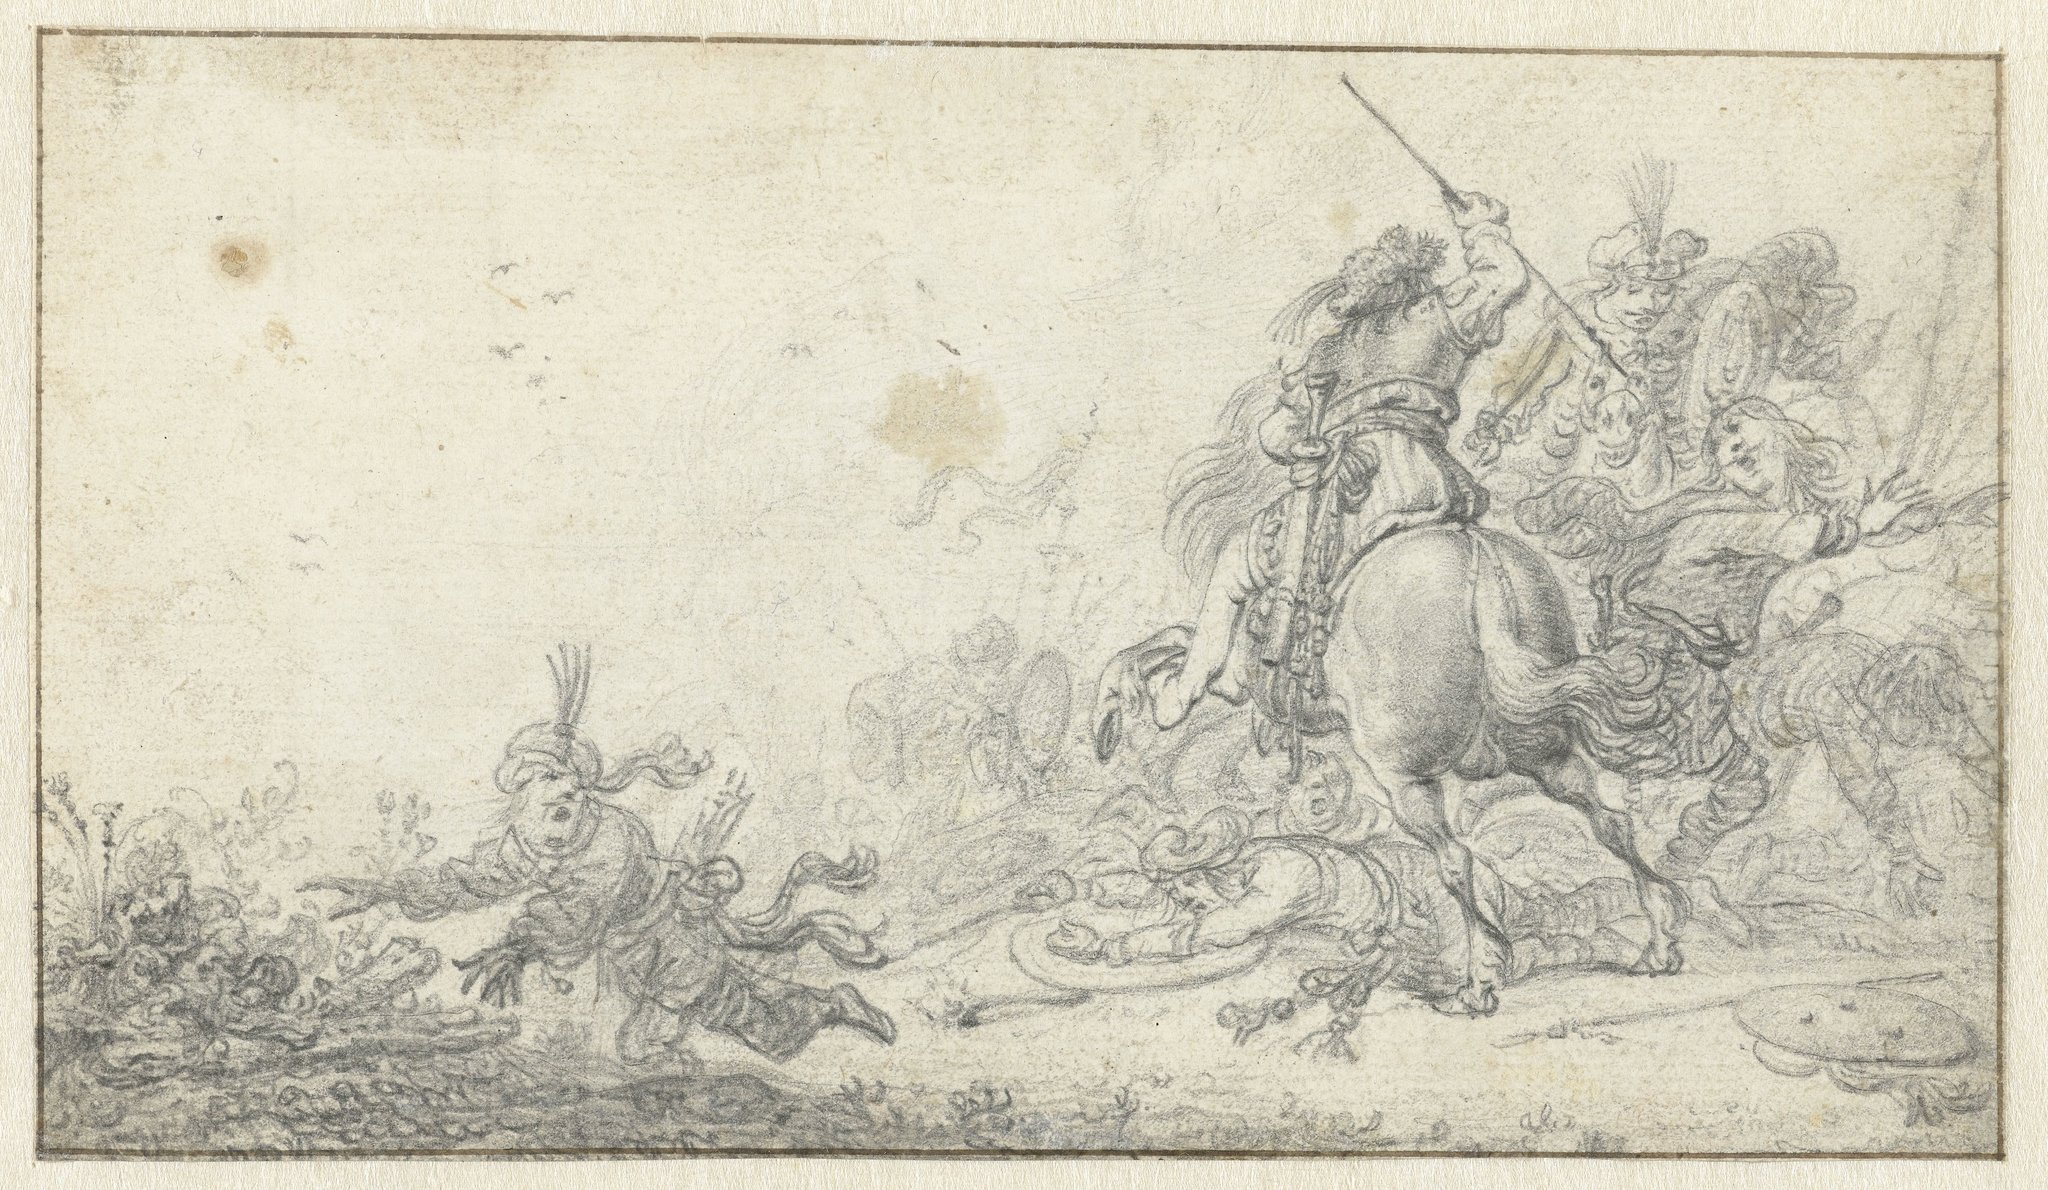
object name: drawing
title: Ruitergevecht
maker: pieter cornelisz. verbeeck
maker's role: draughtsman, print maker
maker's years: 1610-1654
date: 1635-1645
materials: chalk, paper, pencil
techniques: pouncing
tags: battle (+ cavalry, horsemen)